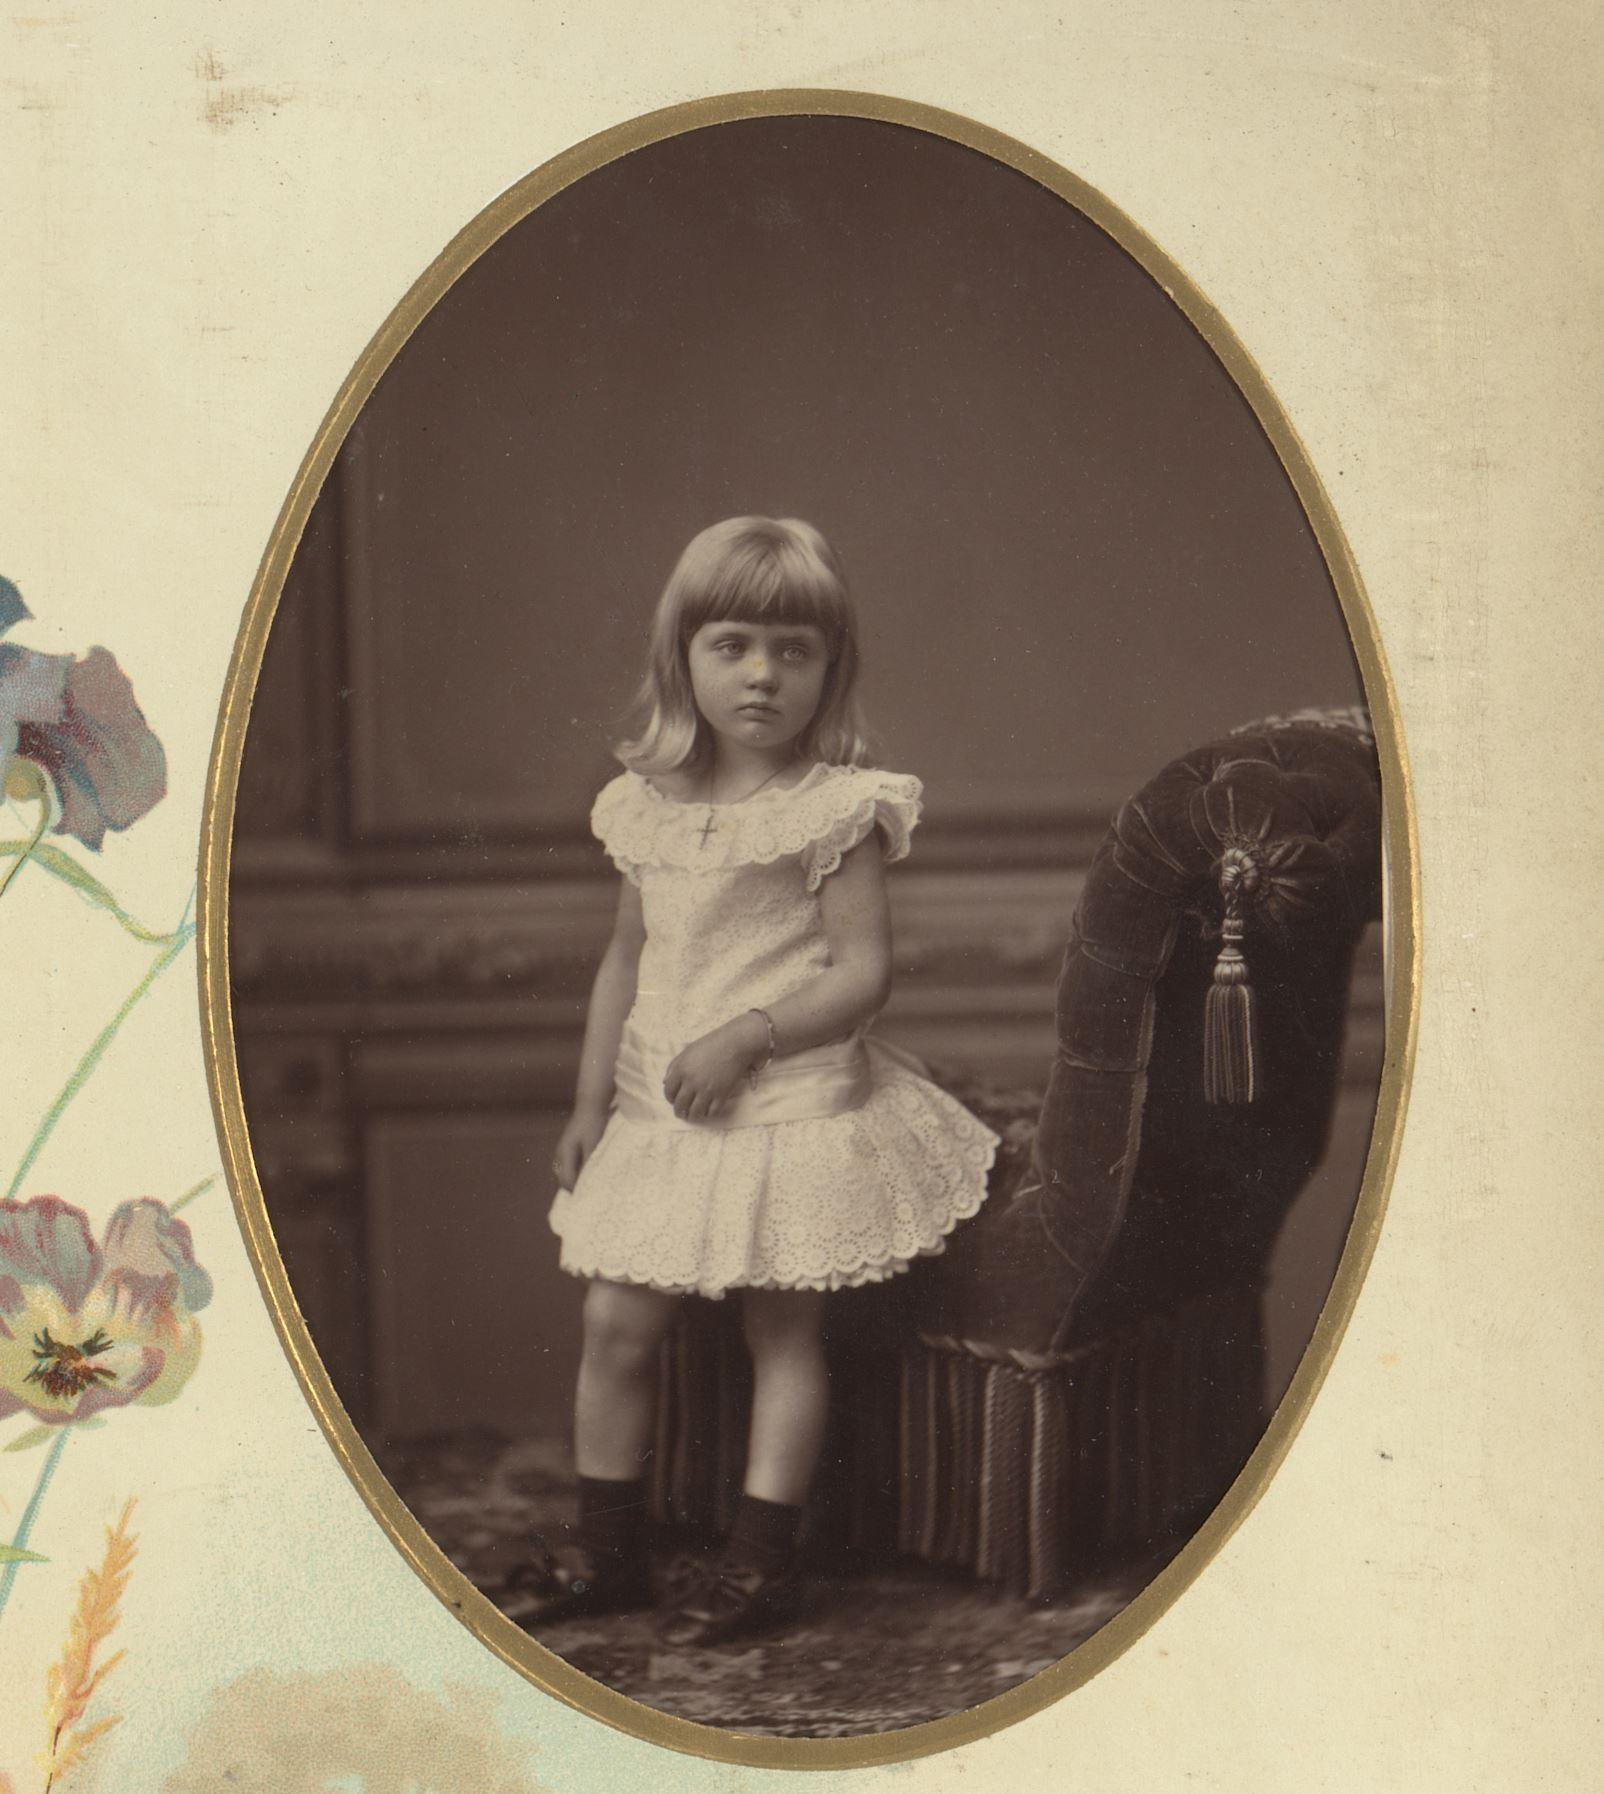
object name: album leaf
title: Portret van een meisje, staand bij een fauteuil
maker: Anonymous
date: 1865-1890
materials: cardboard, paper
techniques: carbon print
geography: belgium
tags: historical persons - bb - woman, toddler (female), chair